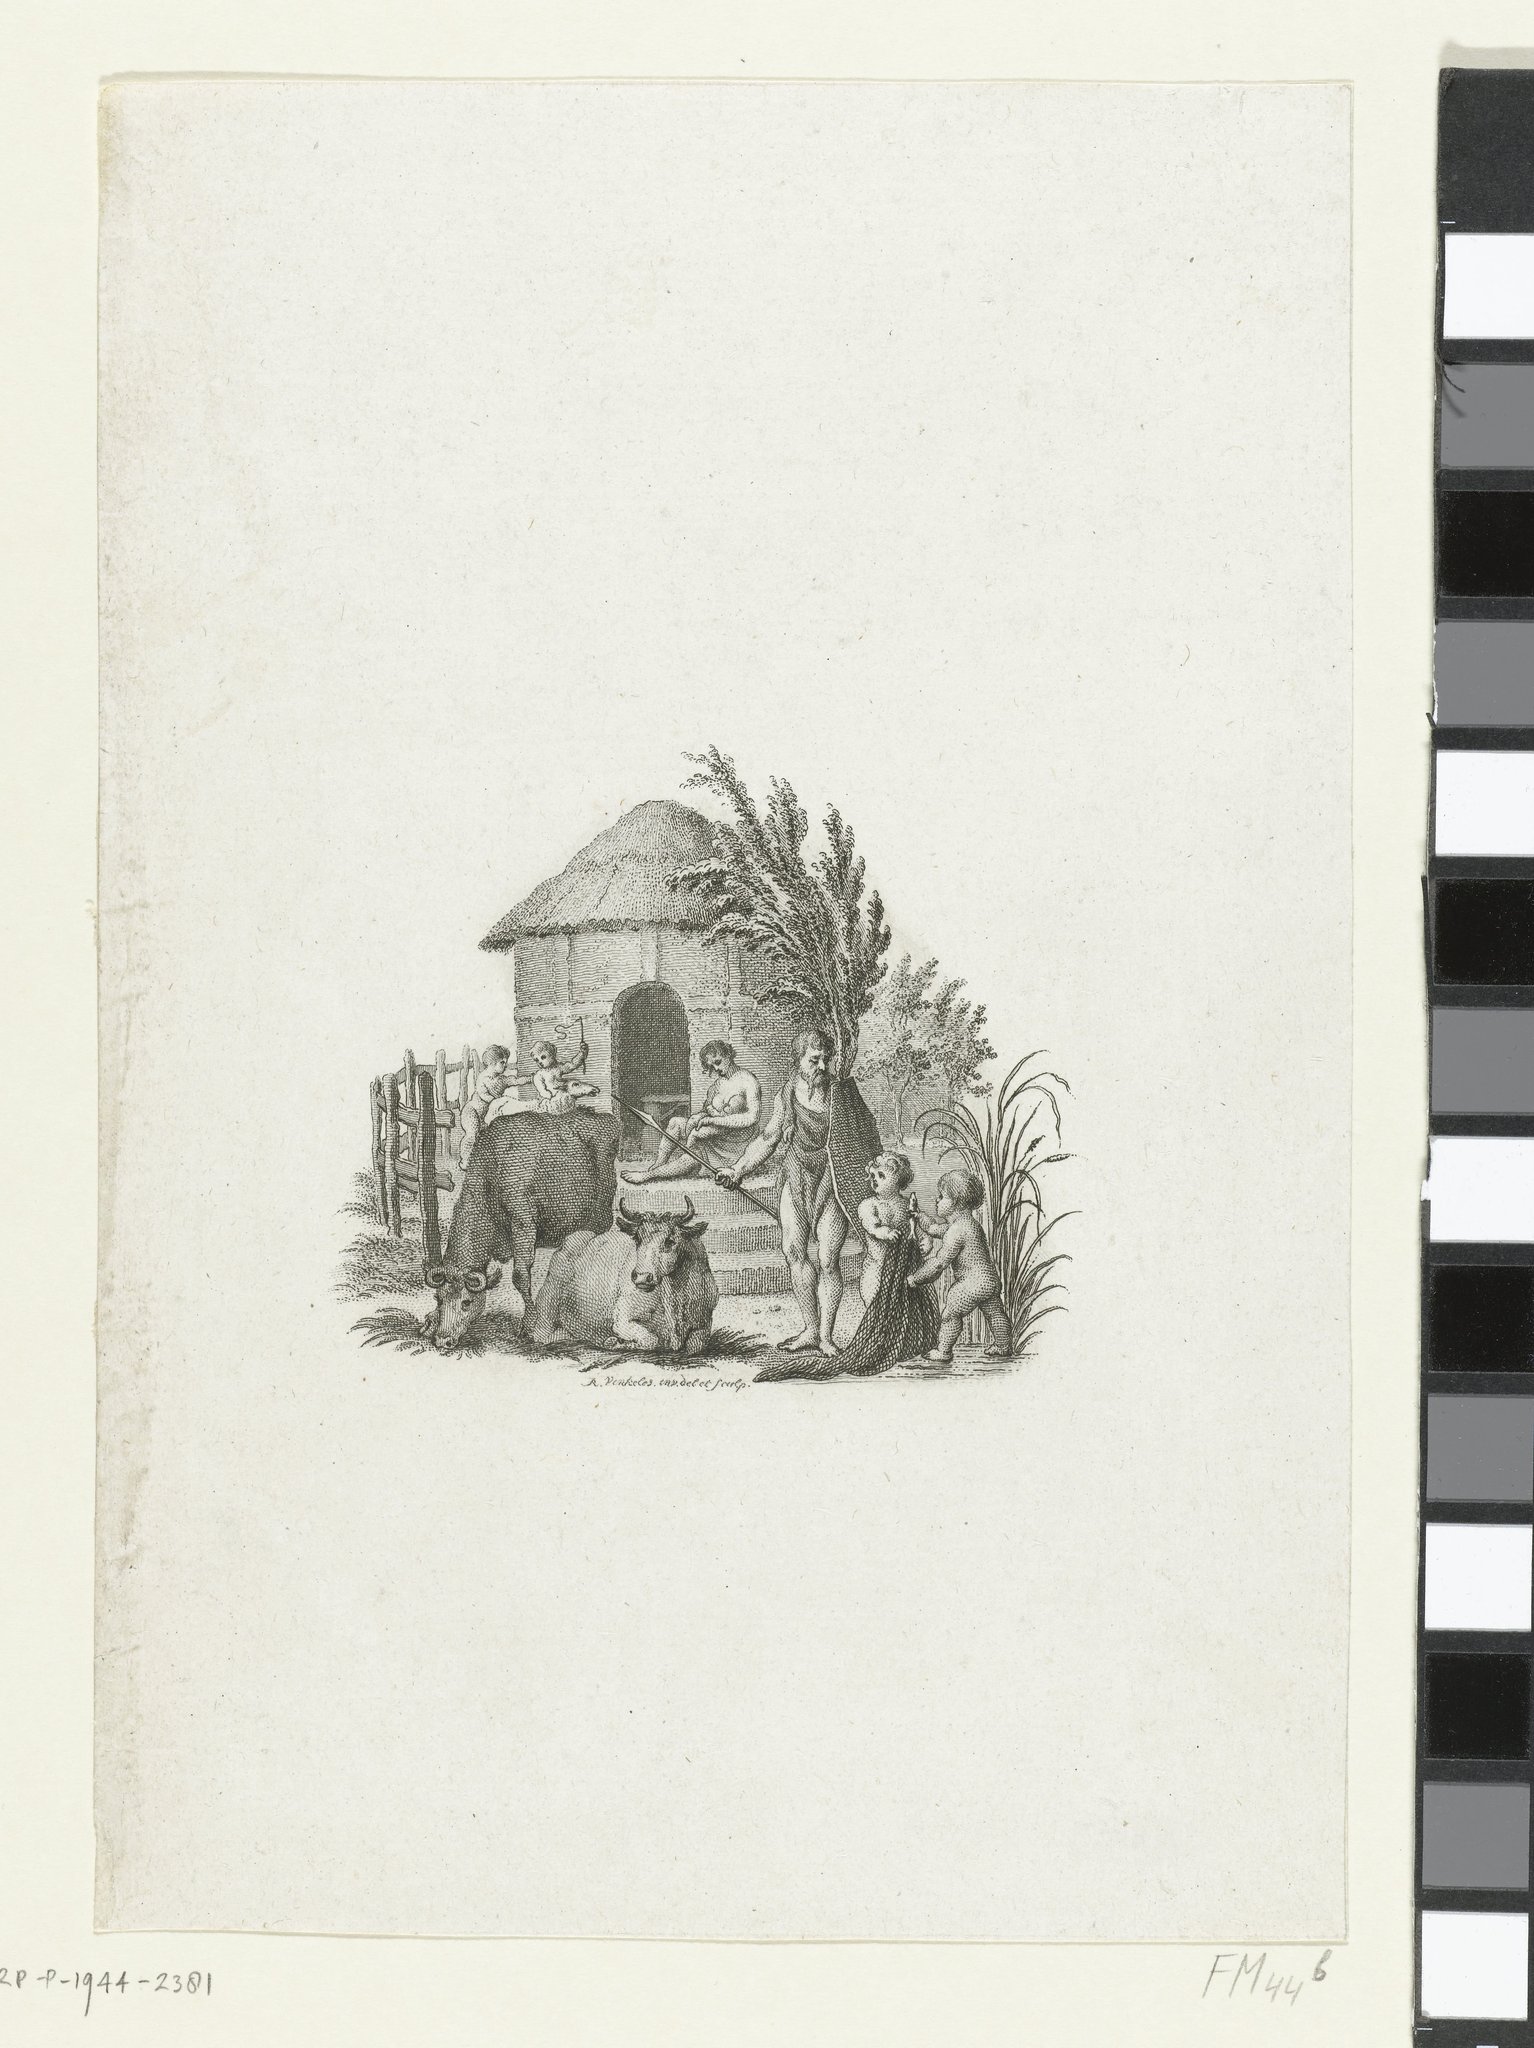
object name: print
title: Titelprent voor Cornelis de Koning, De voorvaderlijke levenswijze en gewoonten hier te lande, 1810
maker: reinier vinkeles (i)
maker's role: draughtsman, print maker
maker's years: 1741-1816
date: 1808-1810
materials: paper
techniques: etching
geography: netherlands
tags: extinct, 'historical' peoples (with name), netherlands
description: Hut met een Bataafse familie en vee. Titelprent voor: Cornelis de Koning, De voorvaderlijke levenswijze en gewoonten hier te lande, François Bohn, Haarlem 1810. Druk vóór de letter.